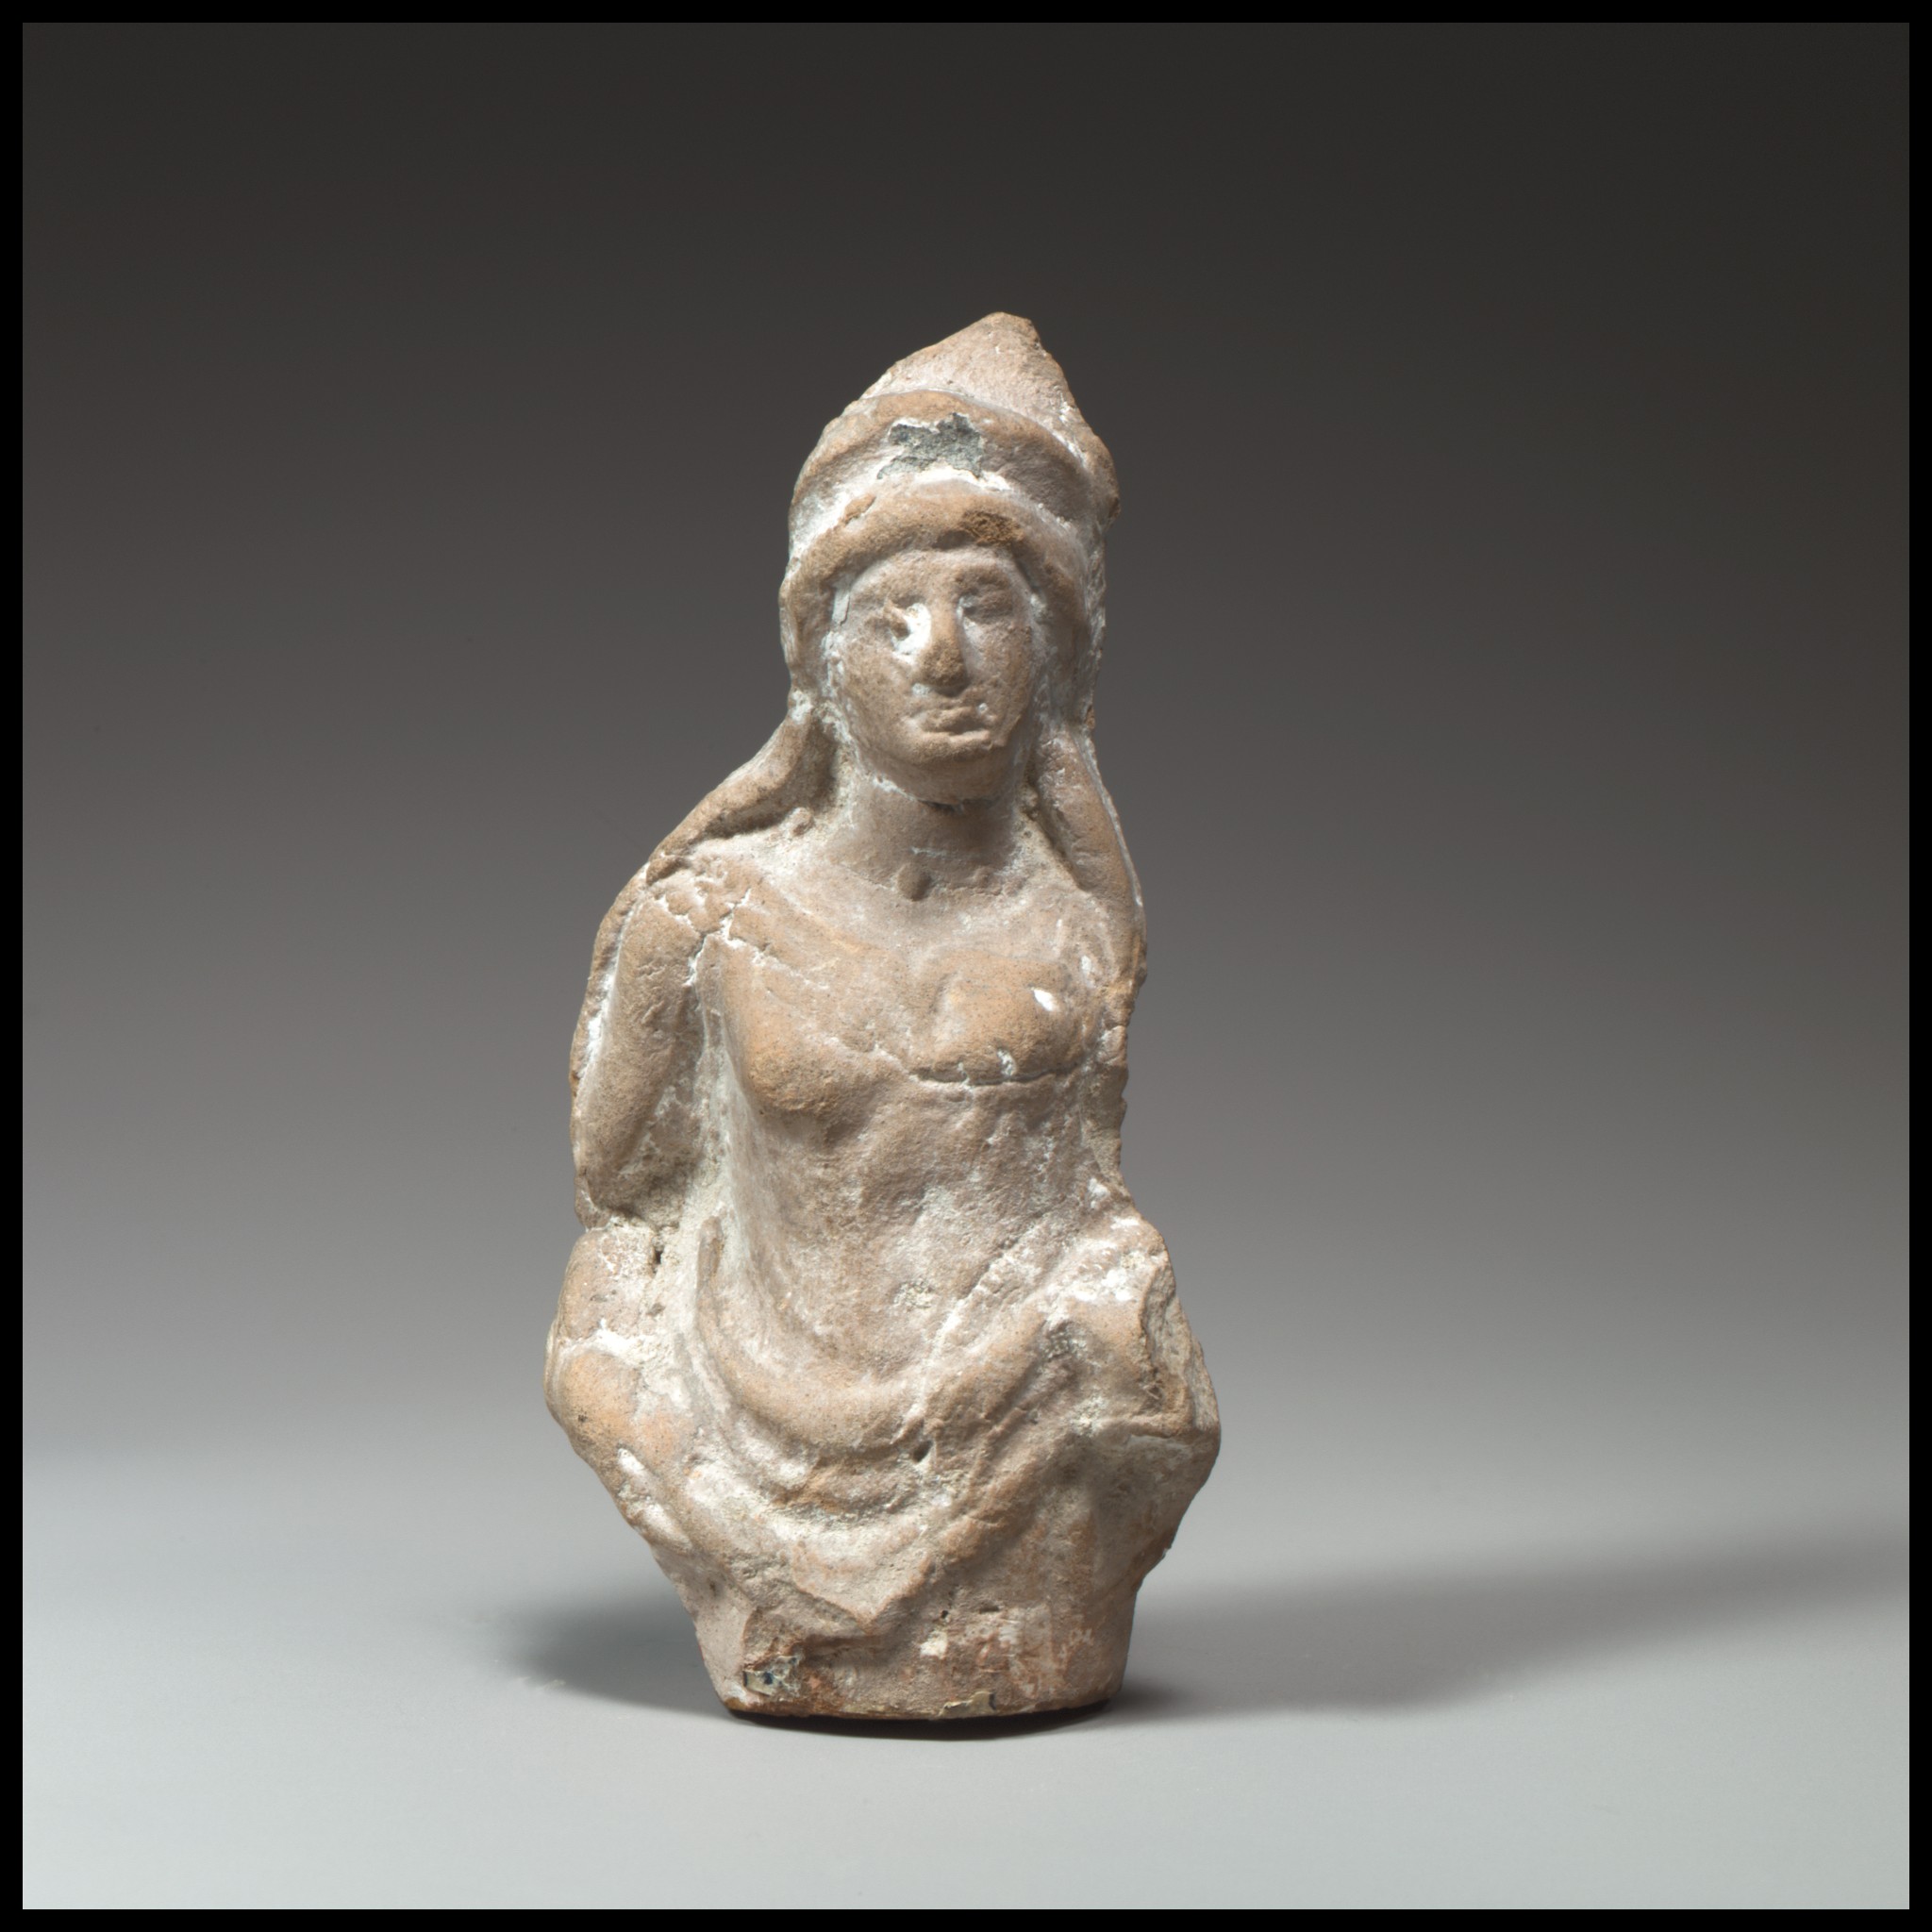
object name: statuette of a woman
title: Standing female figurine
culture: cypriot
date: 200-1 BCE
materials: terracotta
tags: women